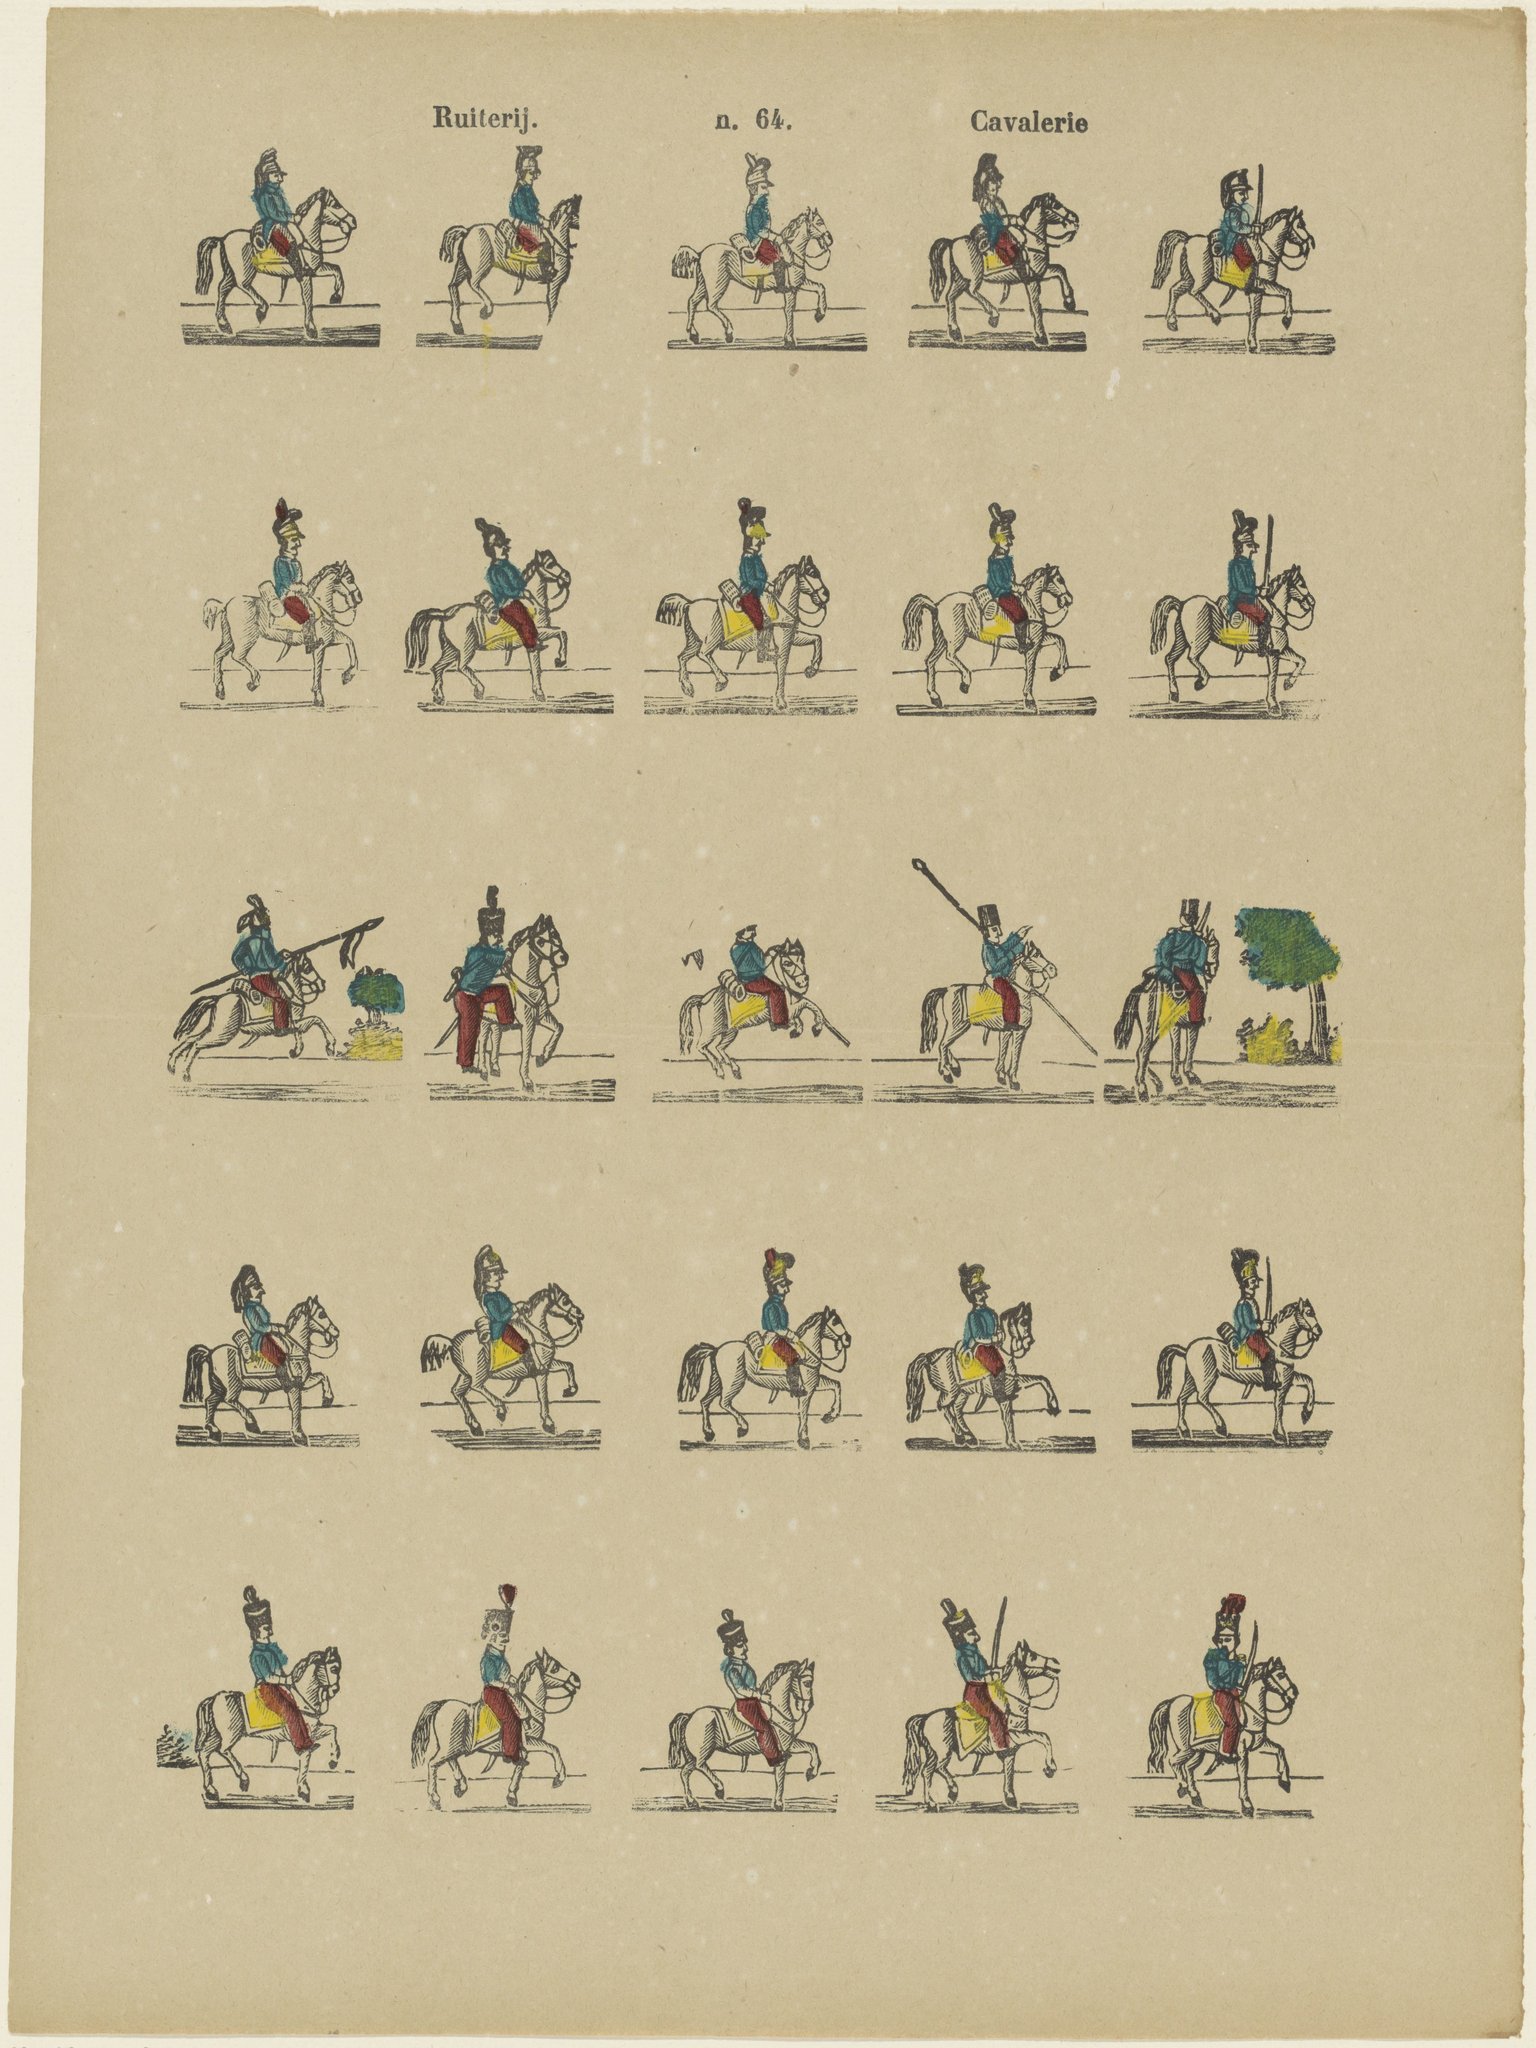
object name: print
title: Ruiterij / Cavalerie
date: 1866-1902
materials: paper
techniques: colour, letterpress printing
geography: europe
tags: warfare; military affairs (+ cavalry, horsemen), the soldier; the soldier's life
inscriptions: collector's mark: Lugt 2760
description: Blad met 25 voorstellingen van militairen te paard. Genummerd midden boven: n. 64.